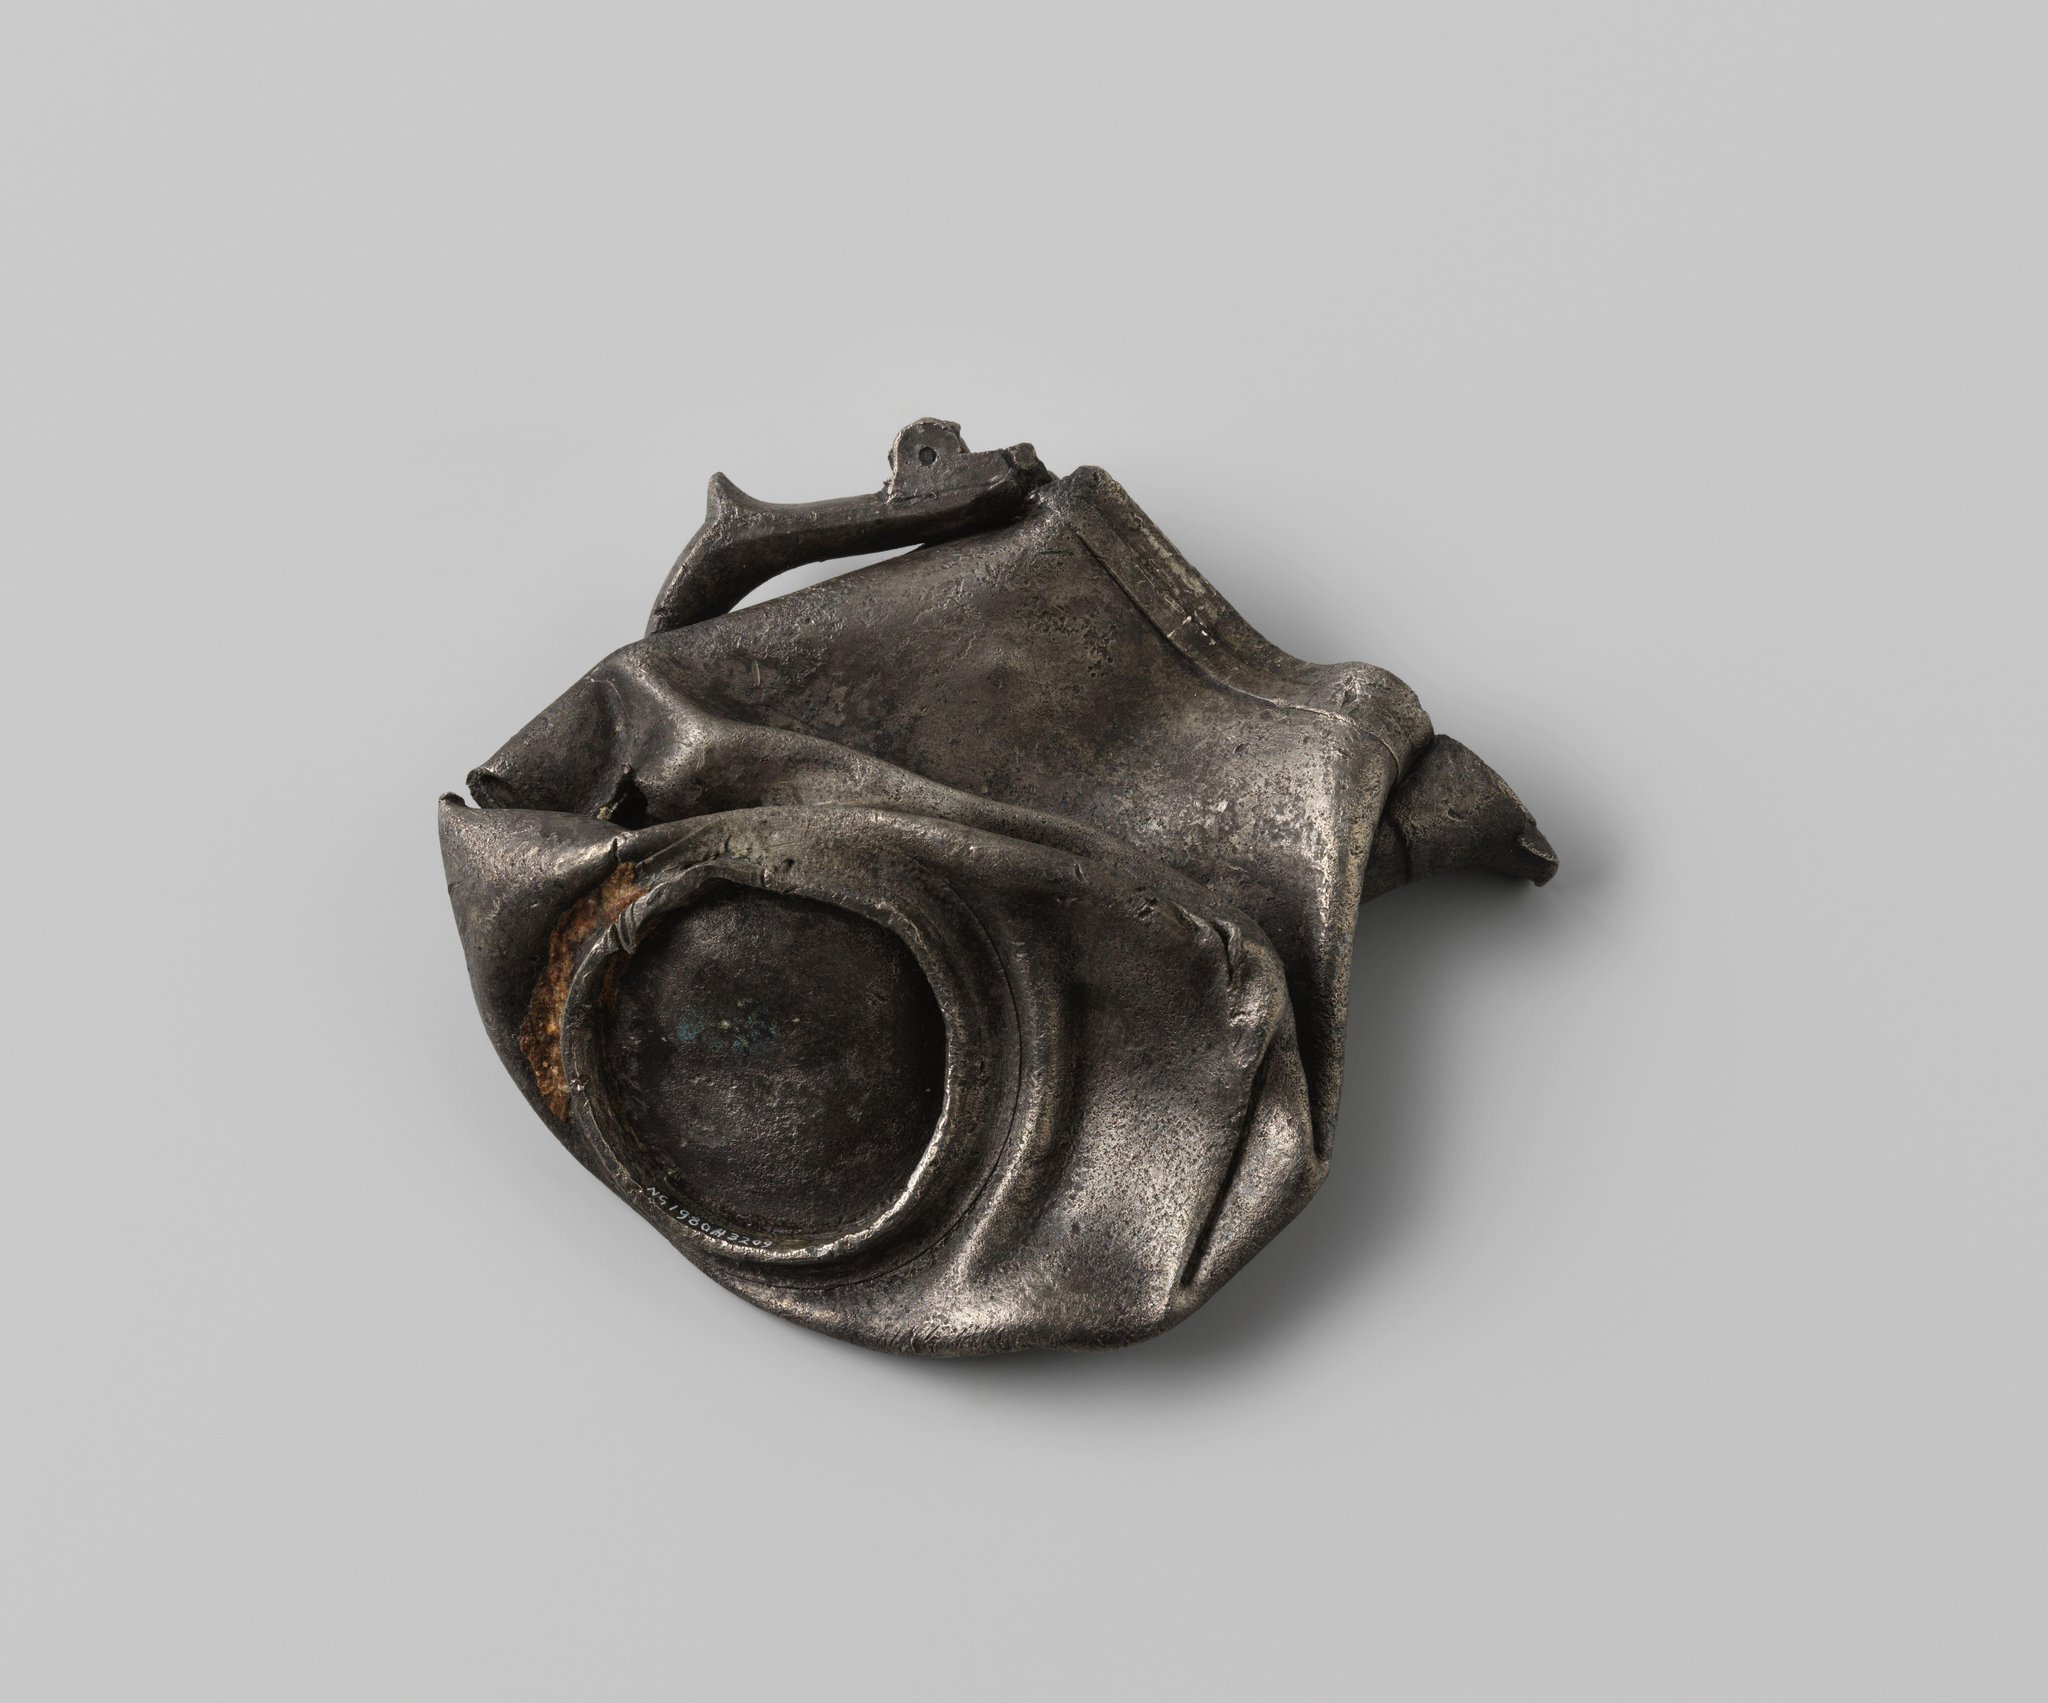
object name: ewer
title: Squashed pewter jug from the wreck of the Dutch East Indiaman Hollandia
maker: Anonymous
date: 1700-1743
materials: tin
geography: netherlands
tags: verenigde oostindische compagnie, hollandia (schip), annet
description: Jug, squashed, lid missing; baluster-shaped, circular base and top, circular footring, conical spout, harp-shaped handle, lens-shaped in section with double-bladed hinge, thumbpiece missing, linear engraving around rim.